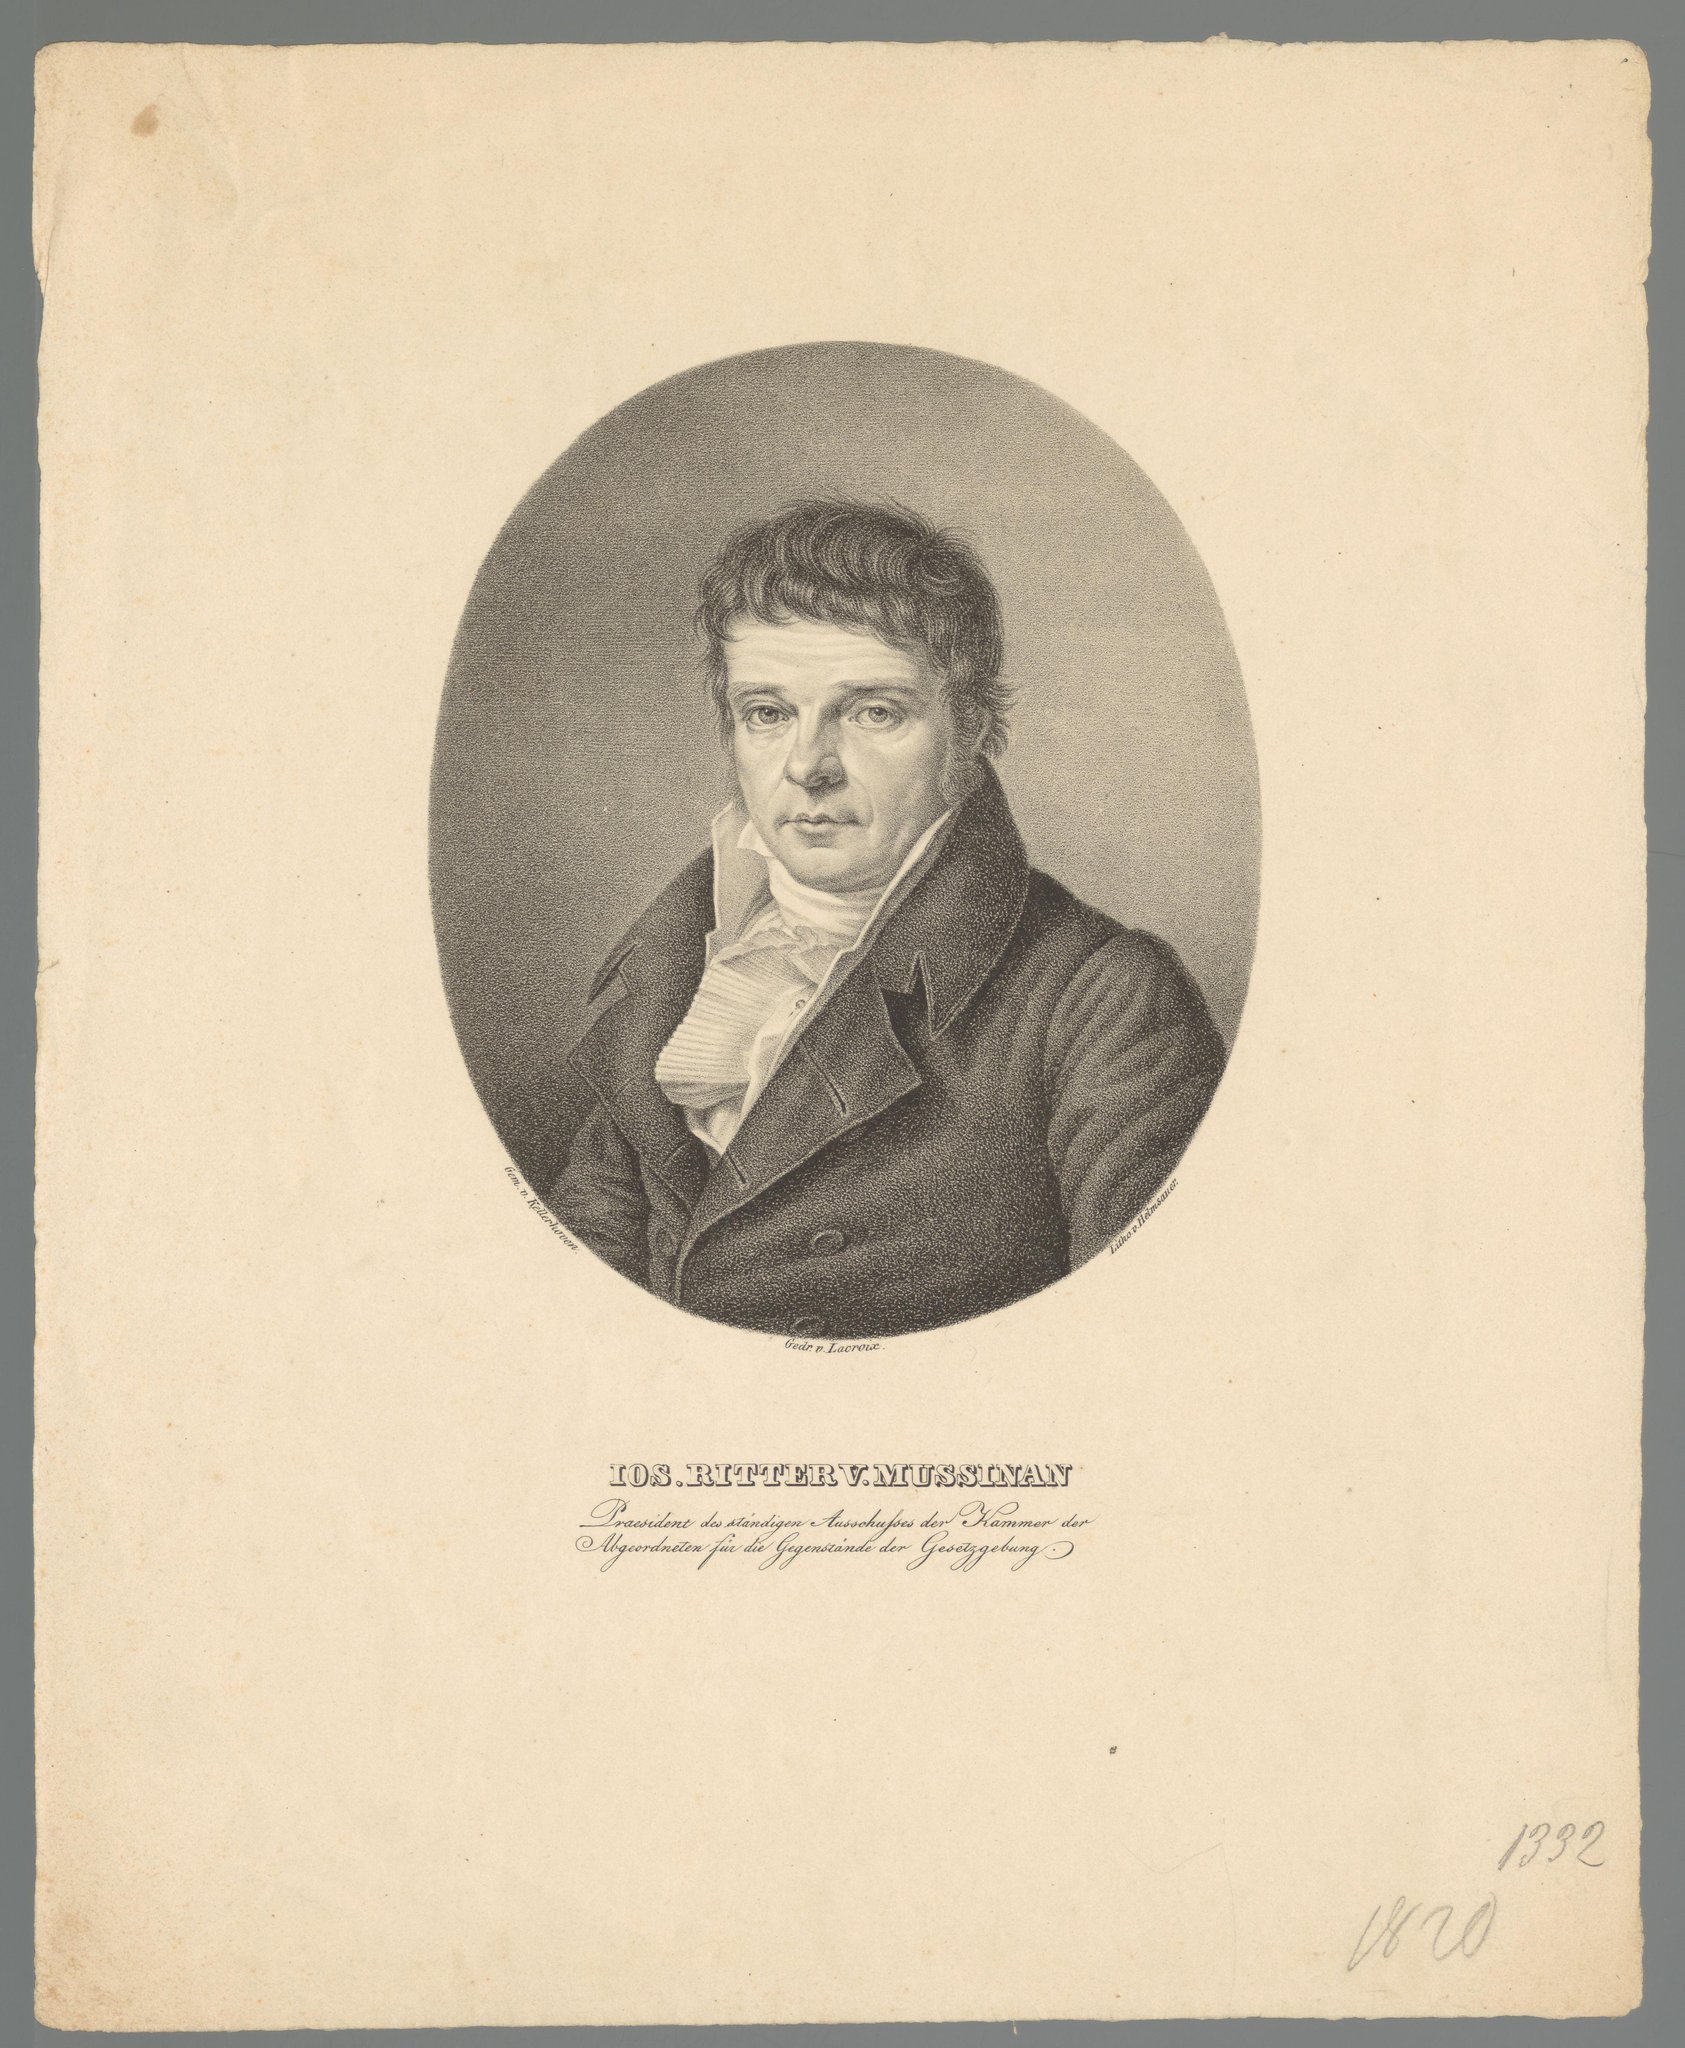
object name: print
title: Ios. Ritter v. Mussinan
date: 1799-1844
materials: paper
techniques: lithograph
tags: historical persons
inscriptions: collector's mark: Lugt 2228